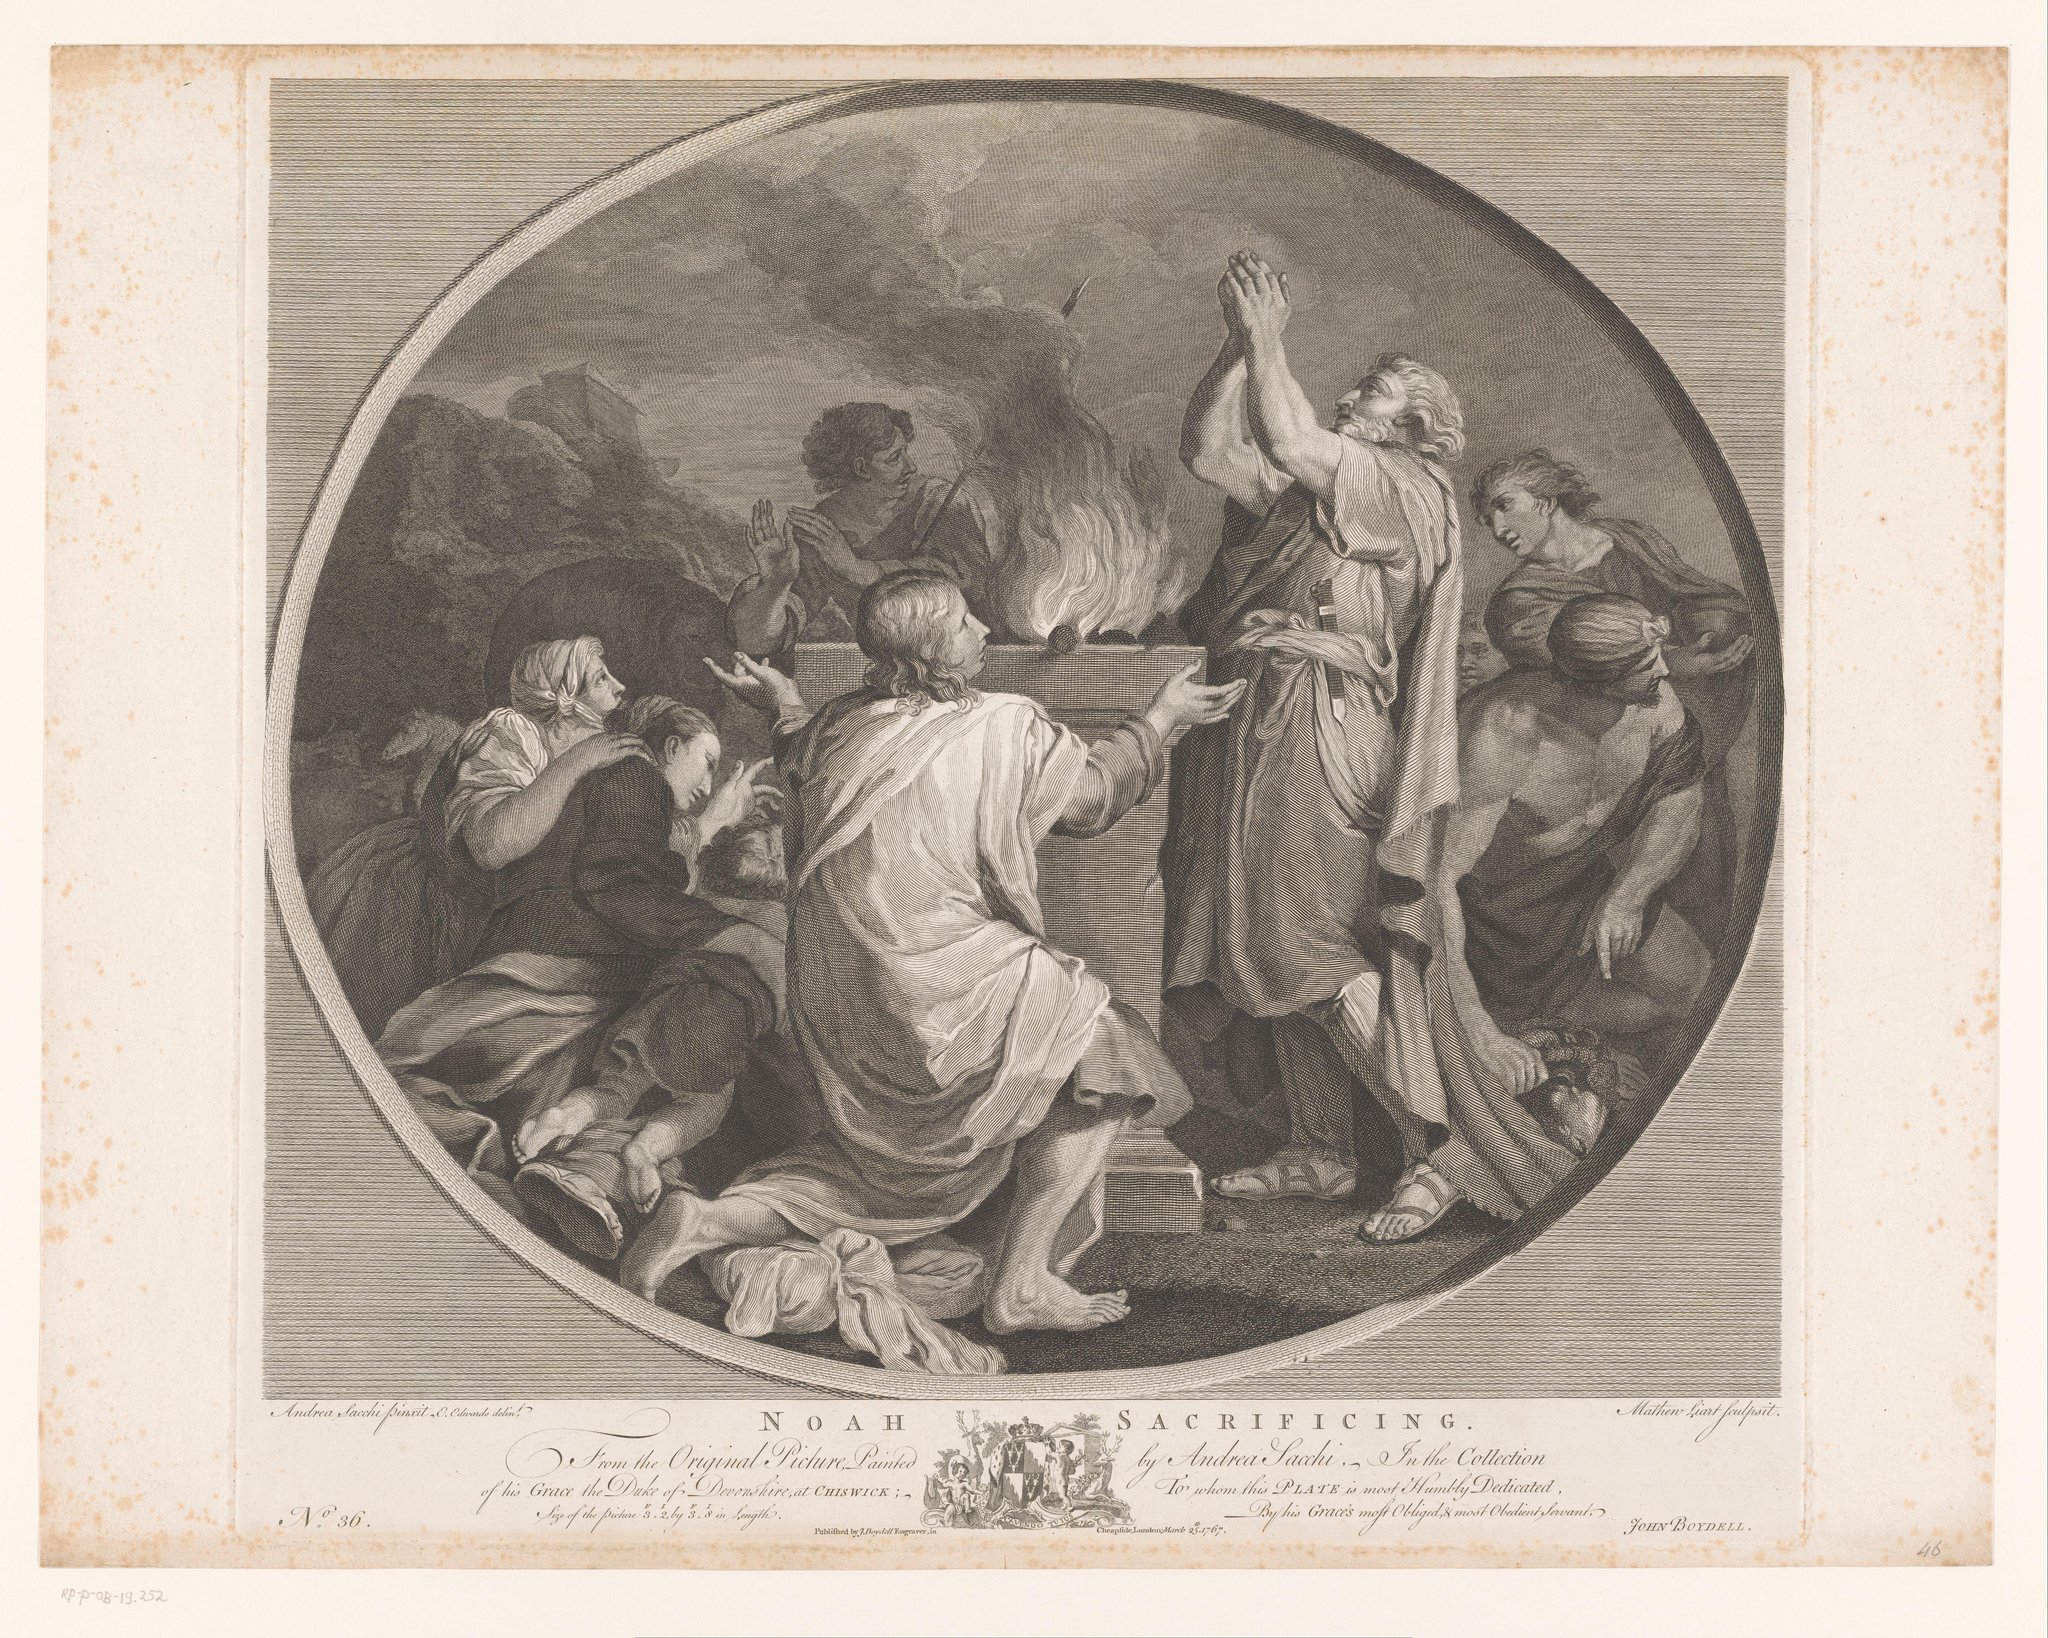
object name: print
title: Voornaamste schilderijen van Engeland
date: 1767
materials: paper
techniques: engraving, etching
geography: london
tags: noah's sacrifice; various animals are offered, possibly a lamb, a dove and a ram (often combined with the rainbow of the covenant)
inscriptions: collector's mark: Lugt 240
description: Prent hoort bij de serie 'The Most Capital Paintings in England', tussen 1763 en 1786 gepubliceerd door John Boydell.